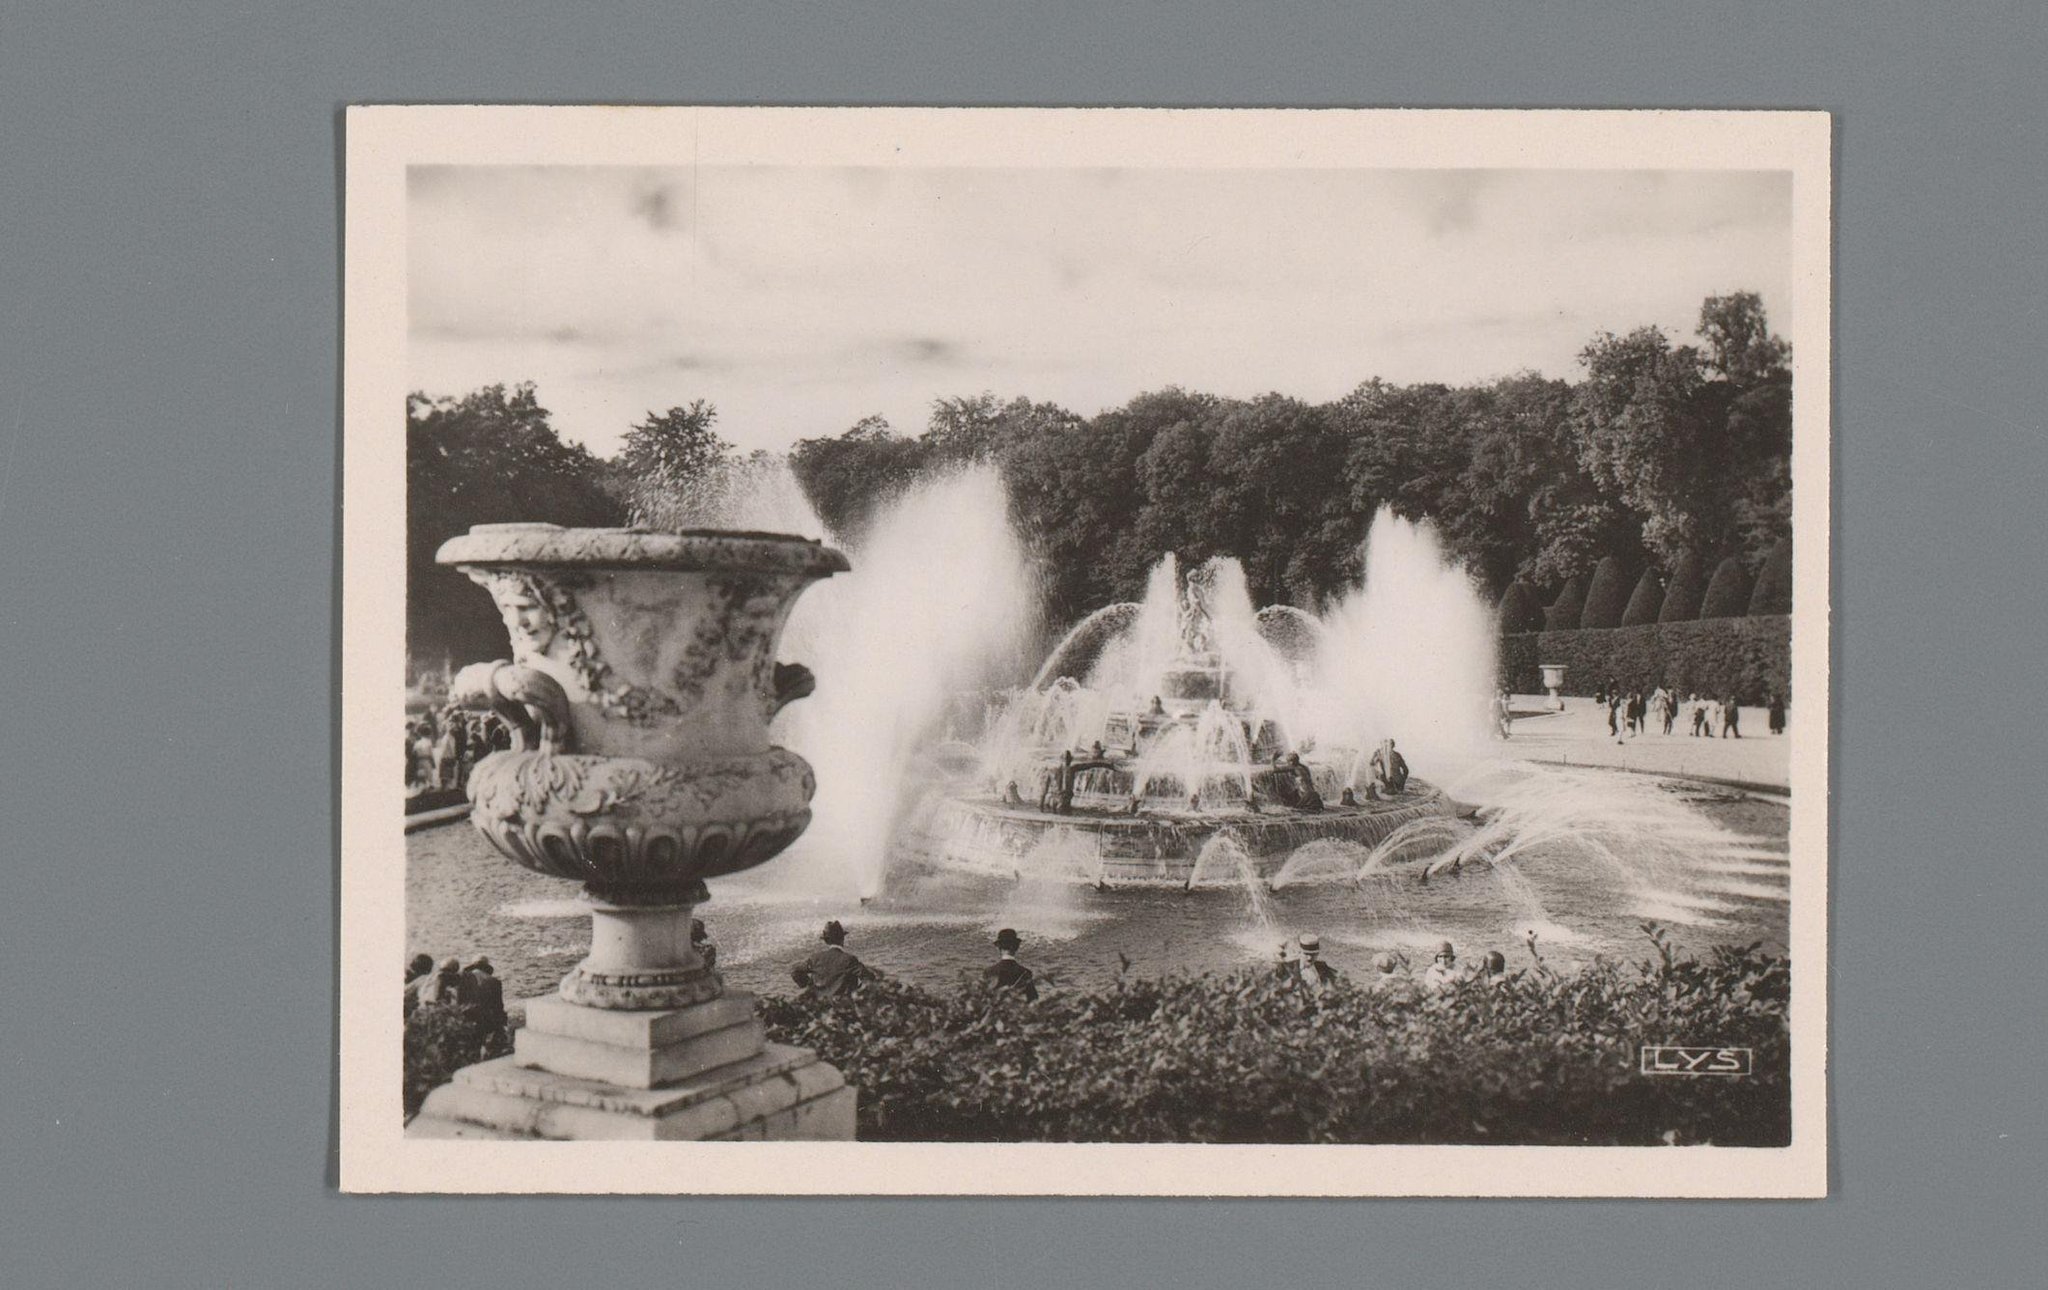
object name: photograph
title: Gezicht op de Latonavijver, Versailles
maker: Anonymous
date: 1900-1920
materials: paper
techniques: gelatin silver print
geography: versailles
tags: ornamental fountain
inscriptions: number: ‘11’